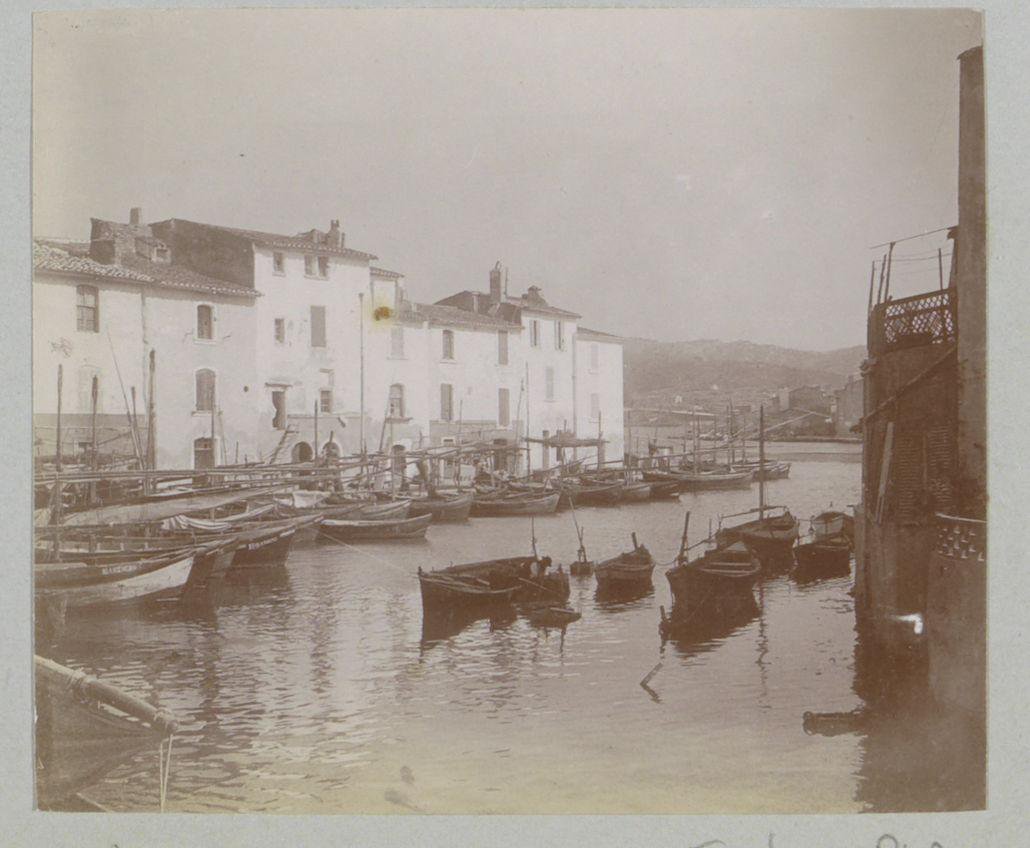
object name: photograph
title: Gezicht op de haven van Martigues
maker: delizy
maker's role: manufacturer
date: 1903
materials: paper, photographic support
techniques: gelatin silver print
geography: martigues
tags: harbour (+ view ~ vehicle, ship, etc.)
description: Onderdeel van Fotoalbum van een Franse amateurfotograaf met opnames van uitstapjes in Frankrijk, Spanje, België, Luxemburg en Nederland, de eerste automobielen en autoraces.